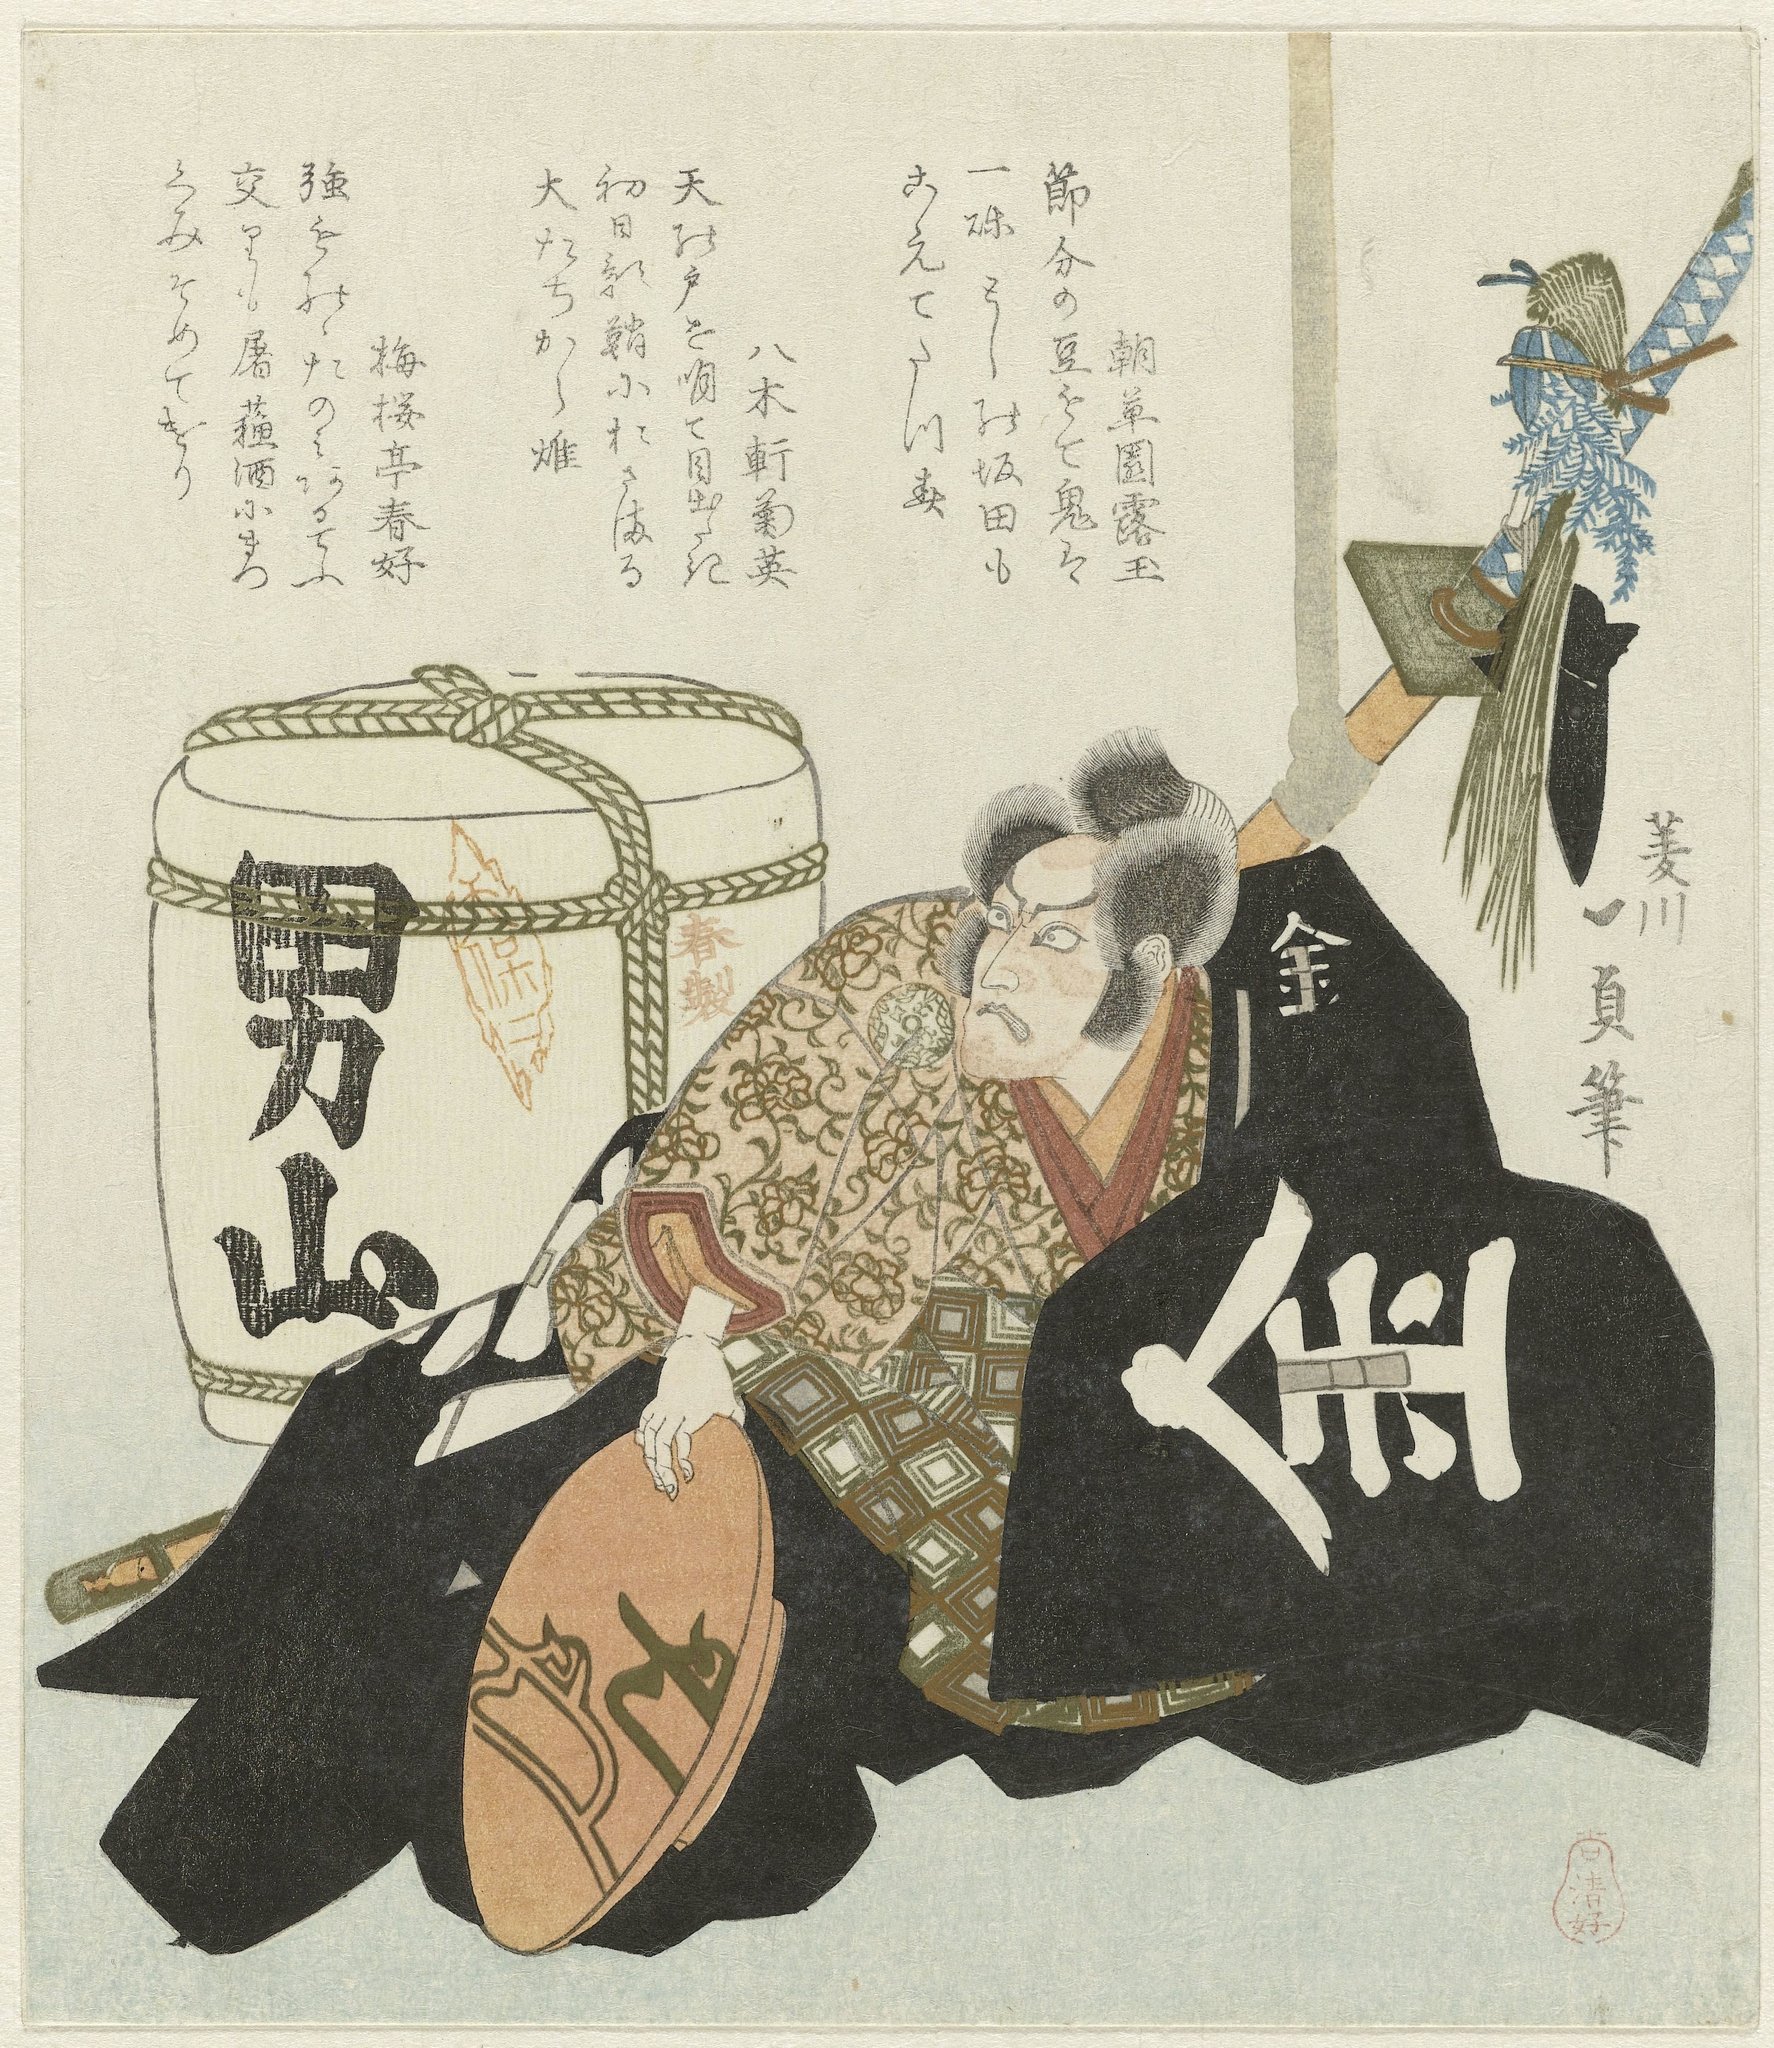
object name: print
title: De acteur Ichikawa Danjuro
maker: kazusada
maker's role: print maker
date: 1831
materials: paper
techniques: woodcut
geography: japan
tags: actor (on the stage)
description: Een surimono is een luxe uitgevoerde prent waarop beeld met één of meerdere gedichten gecombineerd is. Bij het drukken van een surimono werd vaak gebruik gemaakt van dikker papier, blinddruk en metaal pigmenten, zoals koper- en zilverpoeder. De prenten werden vaak in opdracht van dichters gemaakt en als exclusief geschenk aan vrienden en relaties gegeven.